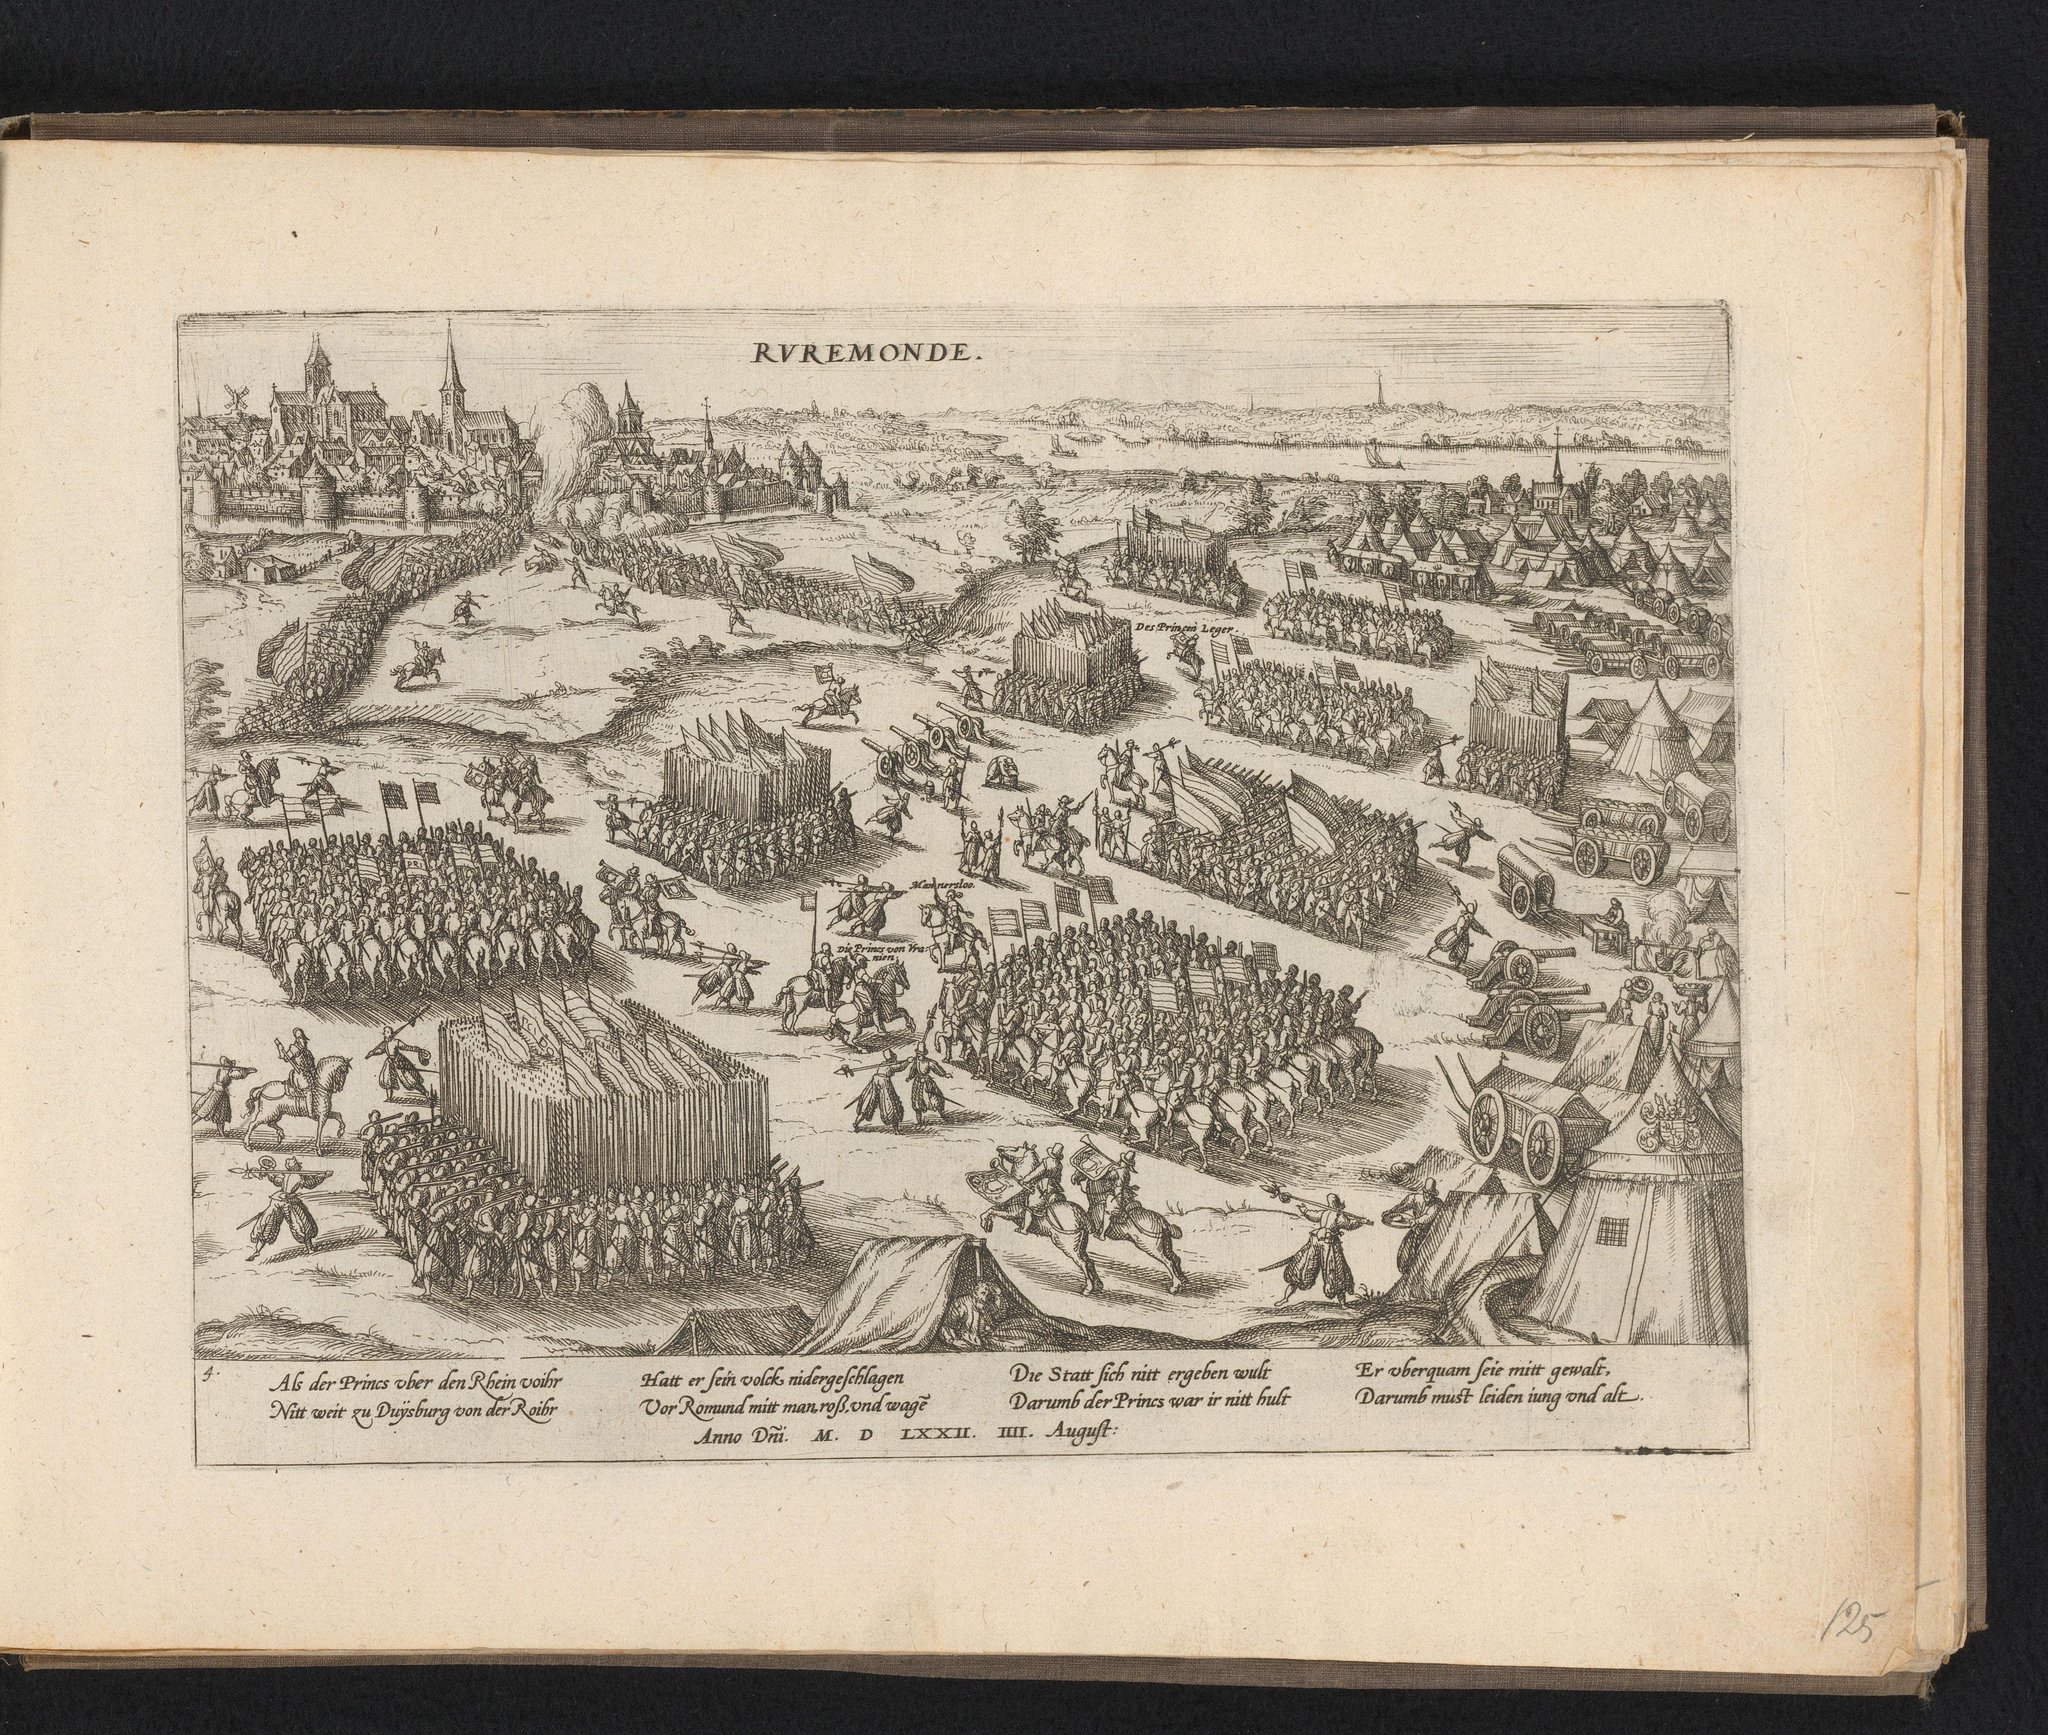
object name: print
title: Roermond door Willem van Oranje ingenomen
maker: frans hogenberg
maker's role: print maker, publisher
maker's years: 1538-1590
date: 1572-1583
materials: paper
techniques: etching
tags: delft, william i (prince of orange), capture of city (after the siege)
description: Prent gebruikt in: Aitsinger, Michael. De Leone Belgico ejusque topographica atque historica descriptione liber (...). S.l.s.n., 1583.